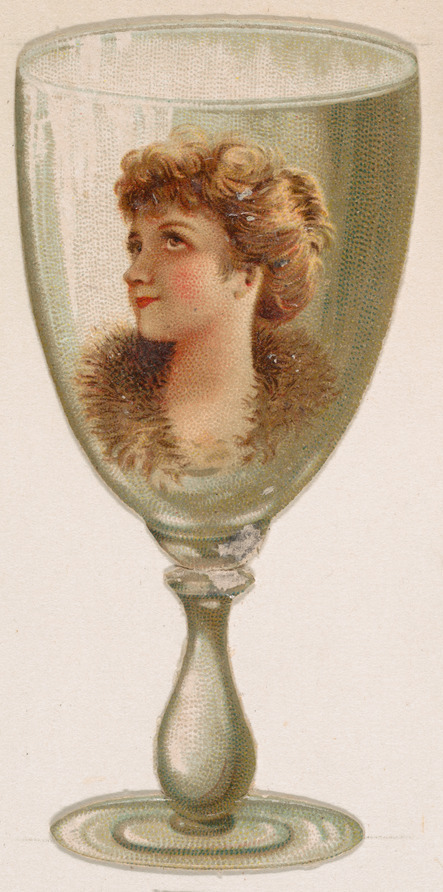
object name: print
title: Goblet, from the Novelties series (N228, Type 3) issued by Kinney Bros.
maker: kinney brothers tobacco company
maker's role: publisher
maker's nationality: american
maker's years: 1869-2011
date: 1889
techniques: color lithograph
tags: women,drinking glasses